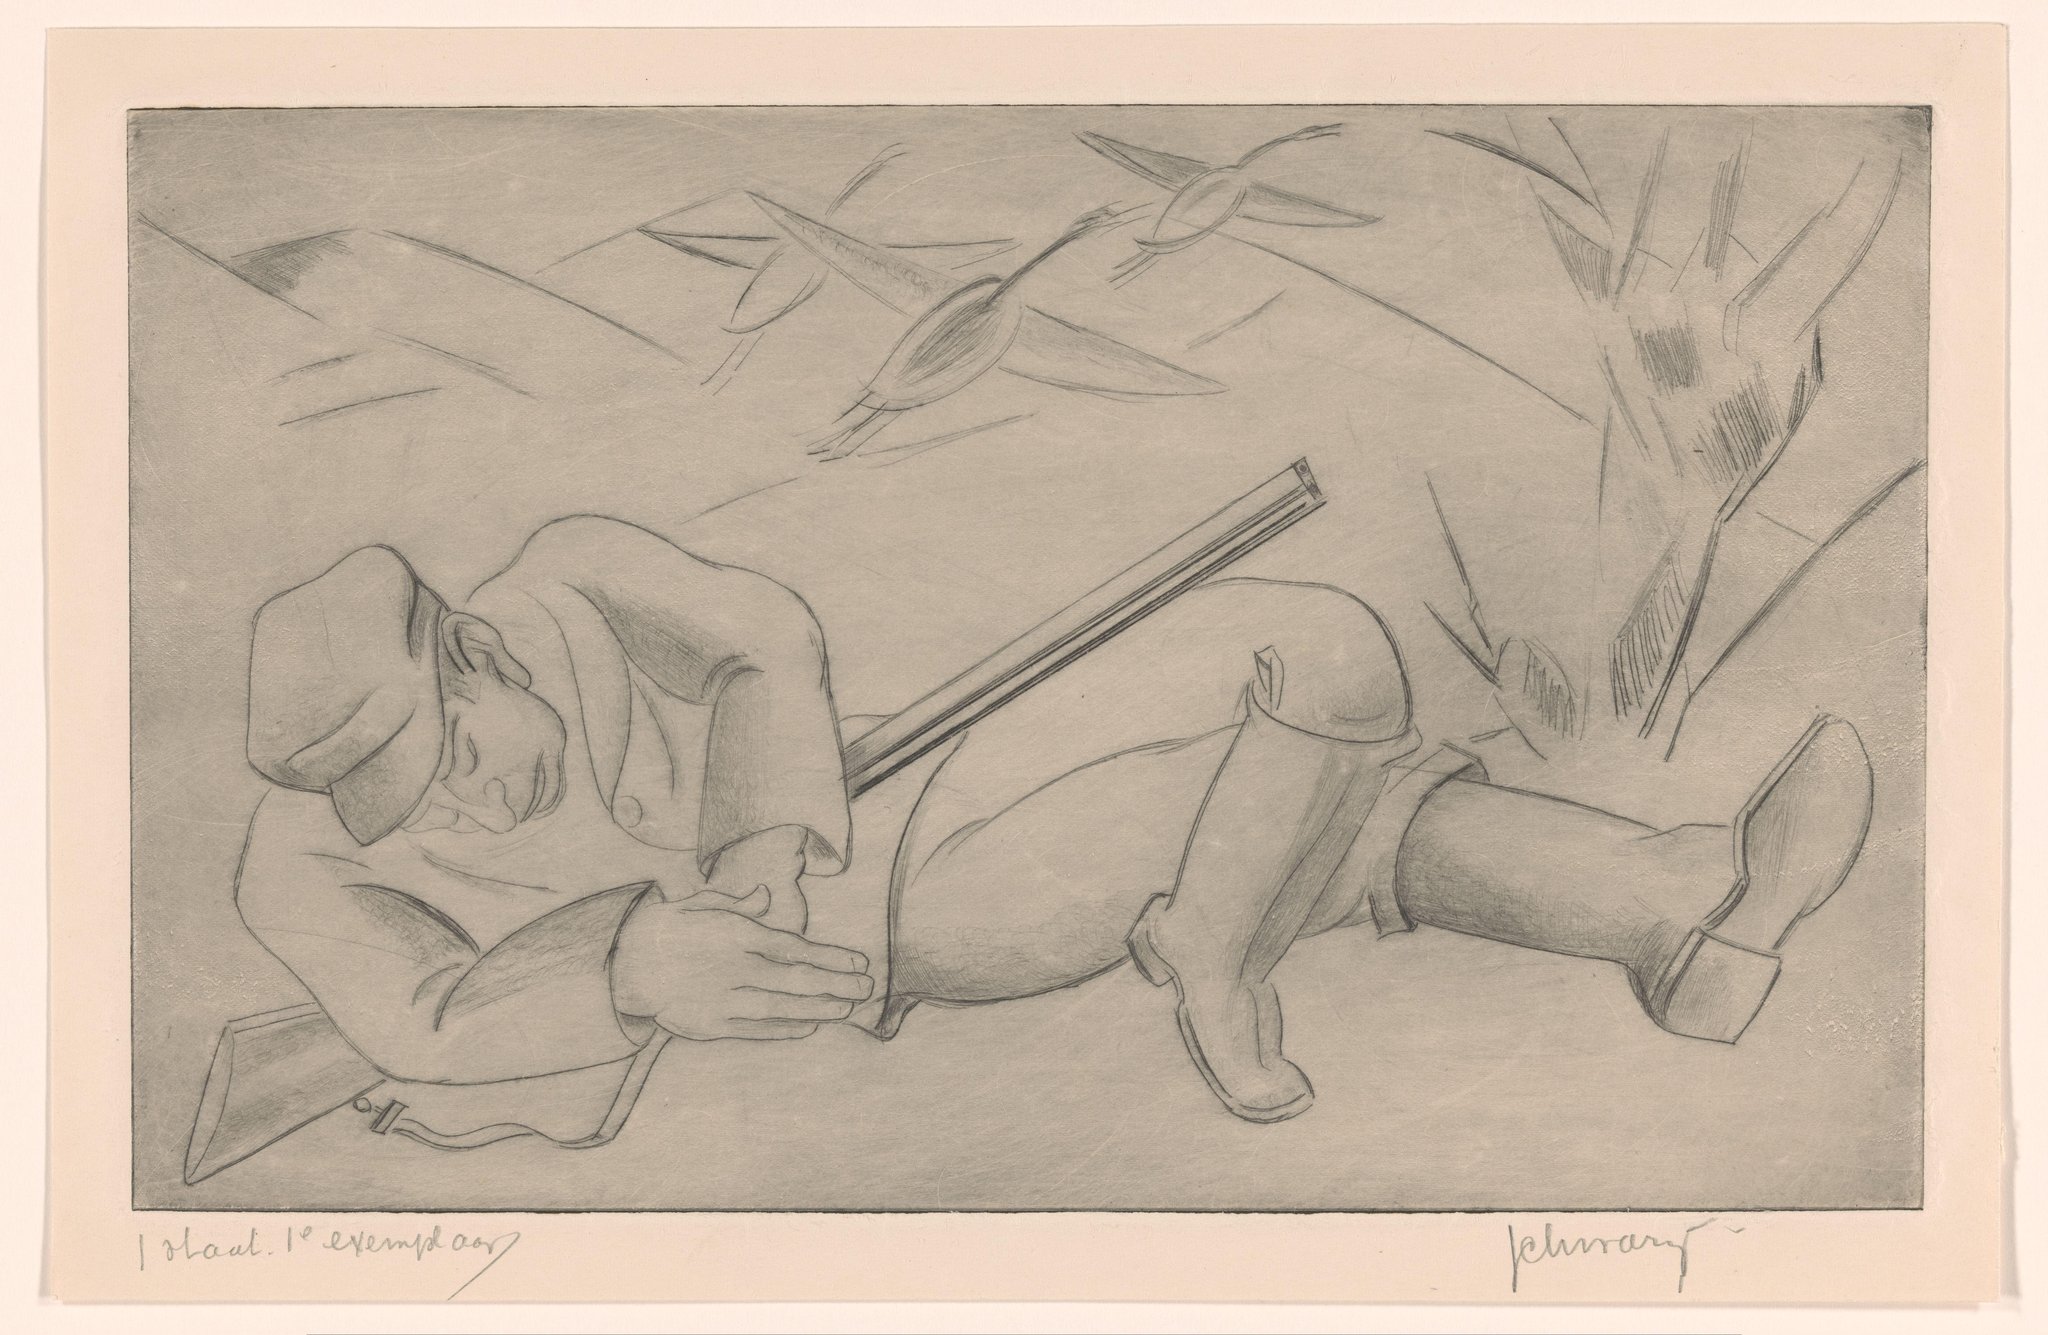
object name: print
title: Slapende jager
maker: mommie schwarz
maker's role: print maker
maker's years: 1876-1942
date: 1886-1931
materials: paper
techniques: drypoint, intaglio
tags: hunters resting during the hunt, sleeping; unconsciousness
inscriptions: collector's mark: Lugt 2228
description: Een jager ligt te slapen met zijn geweer in zijn armen. Achter hem vliegen drie vogels weg.